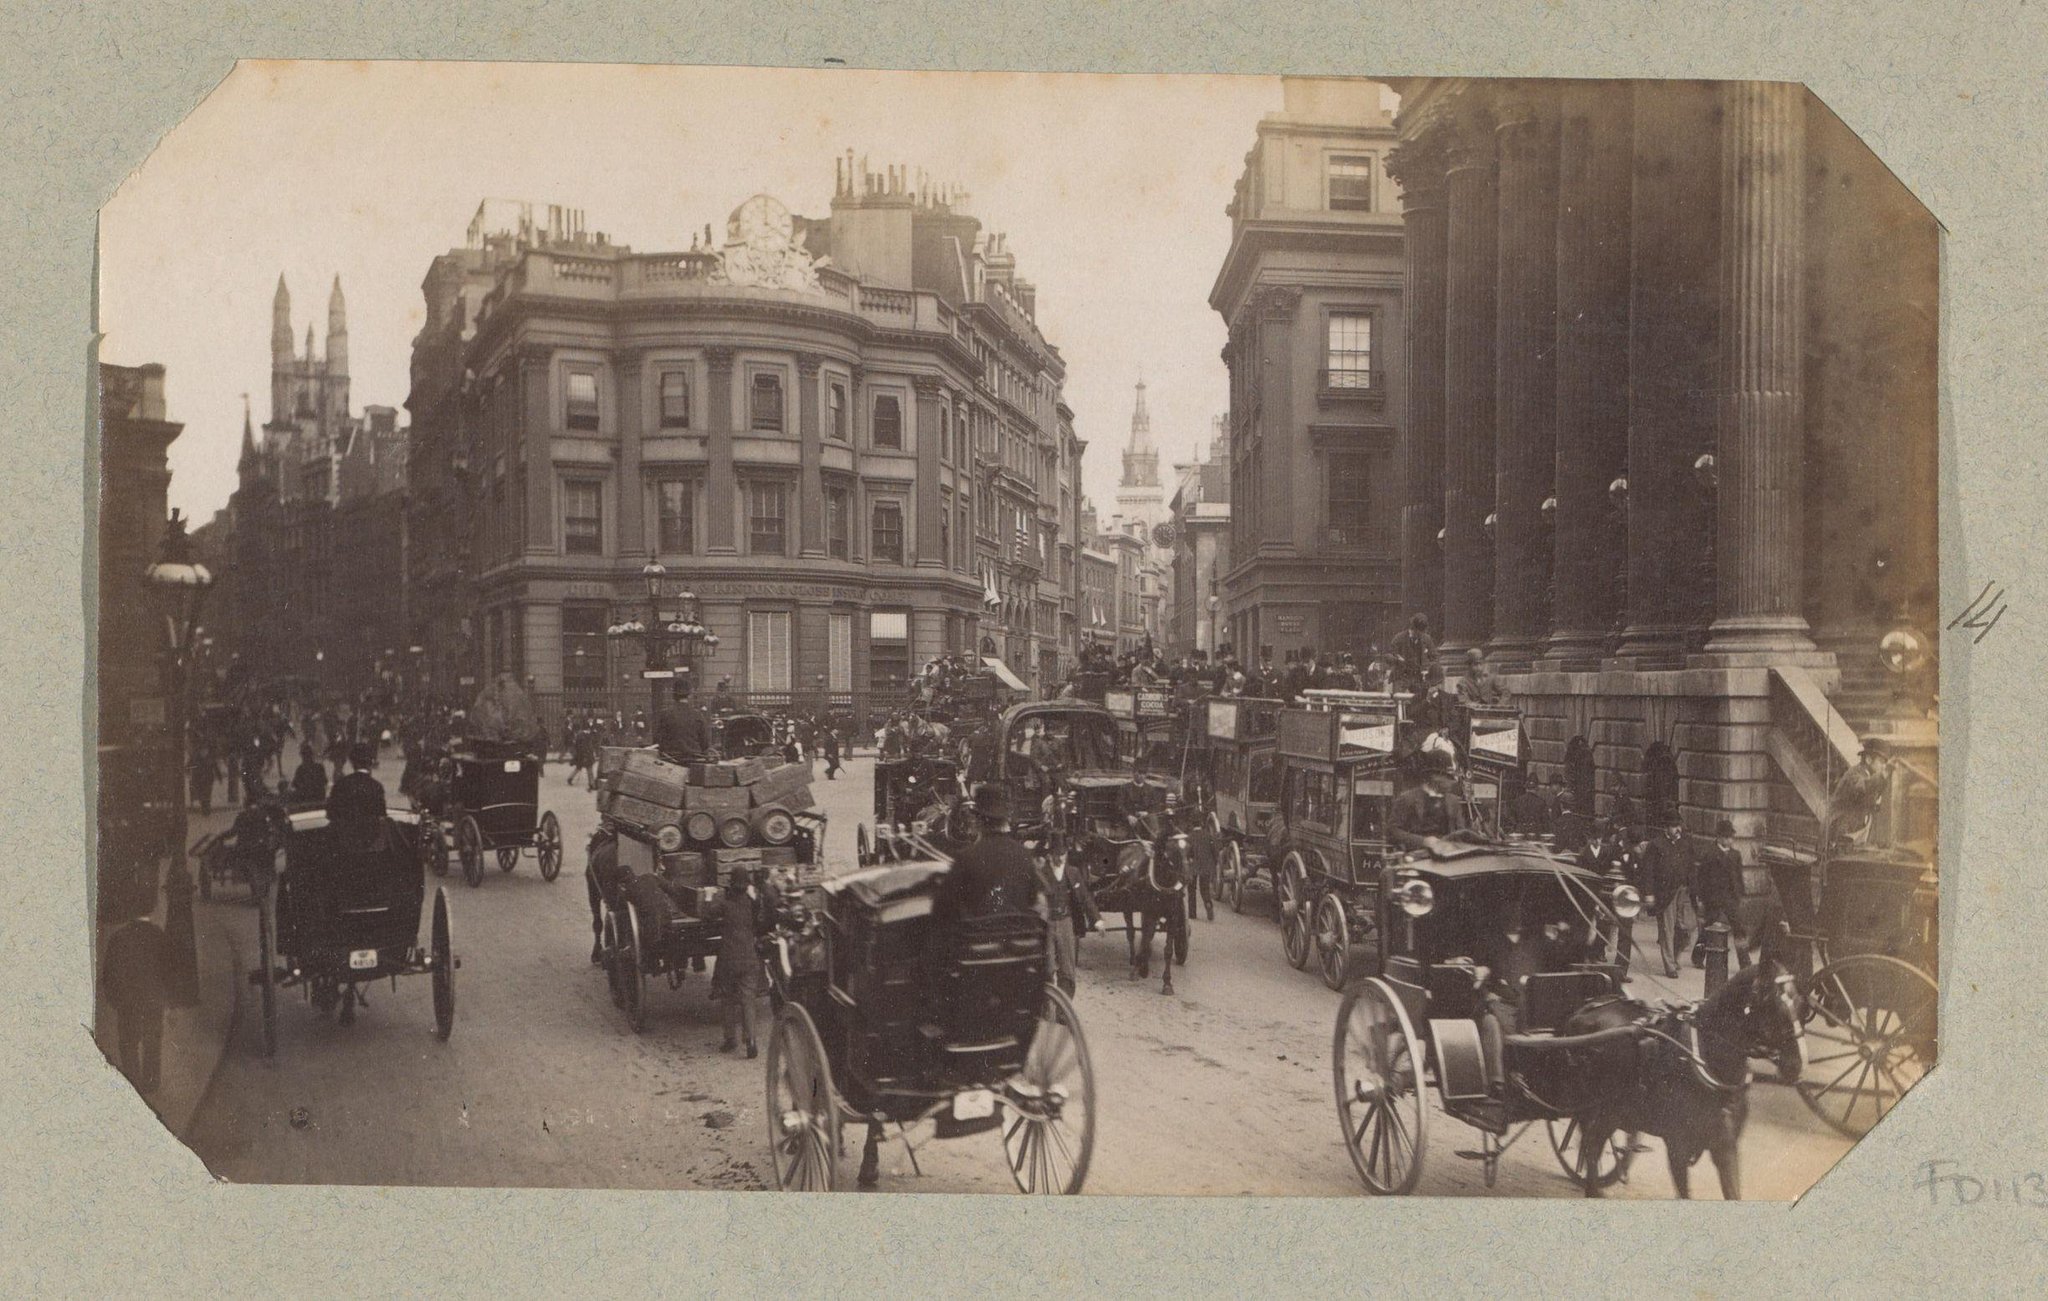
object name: album leaf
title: New Law Court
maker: Anonymous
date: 1880-1910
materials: paper, photographic support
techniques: albumen print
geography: london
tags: court building, london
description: Onderdeel van Reisalbum met bezienswaardigheden in Engeland, Zwitserland, Frankrijk en Duitsland.